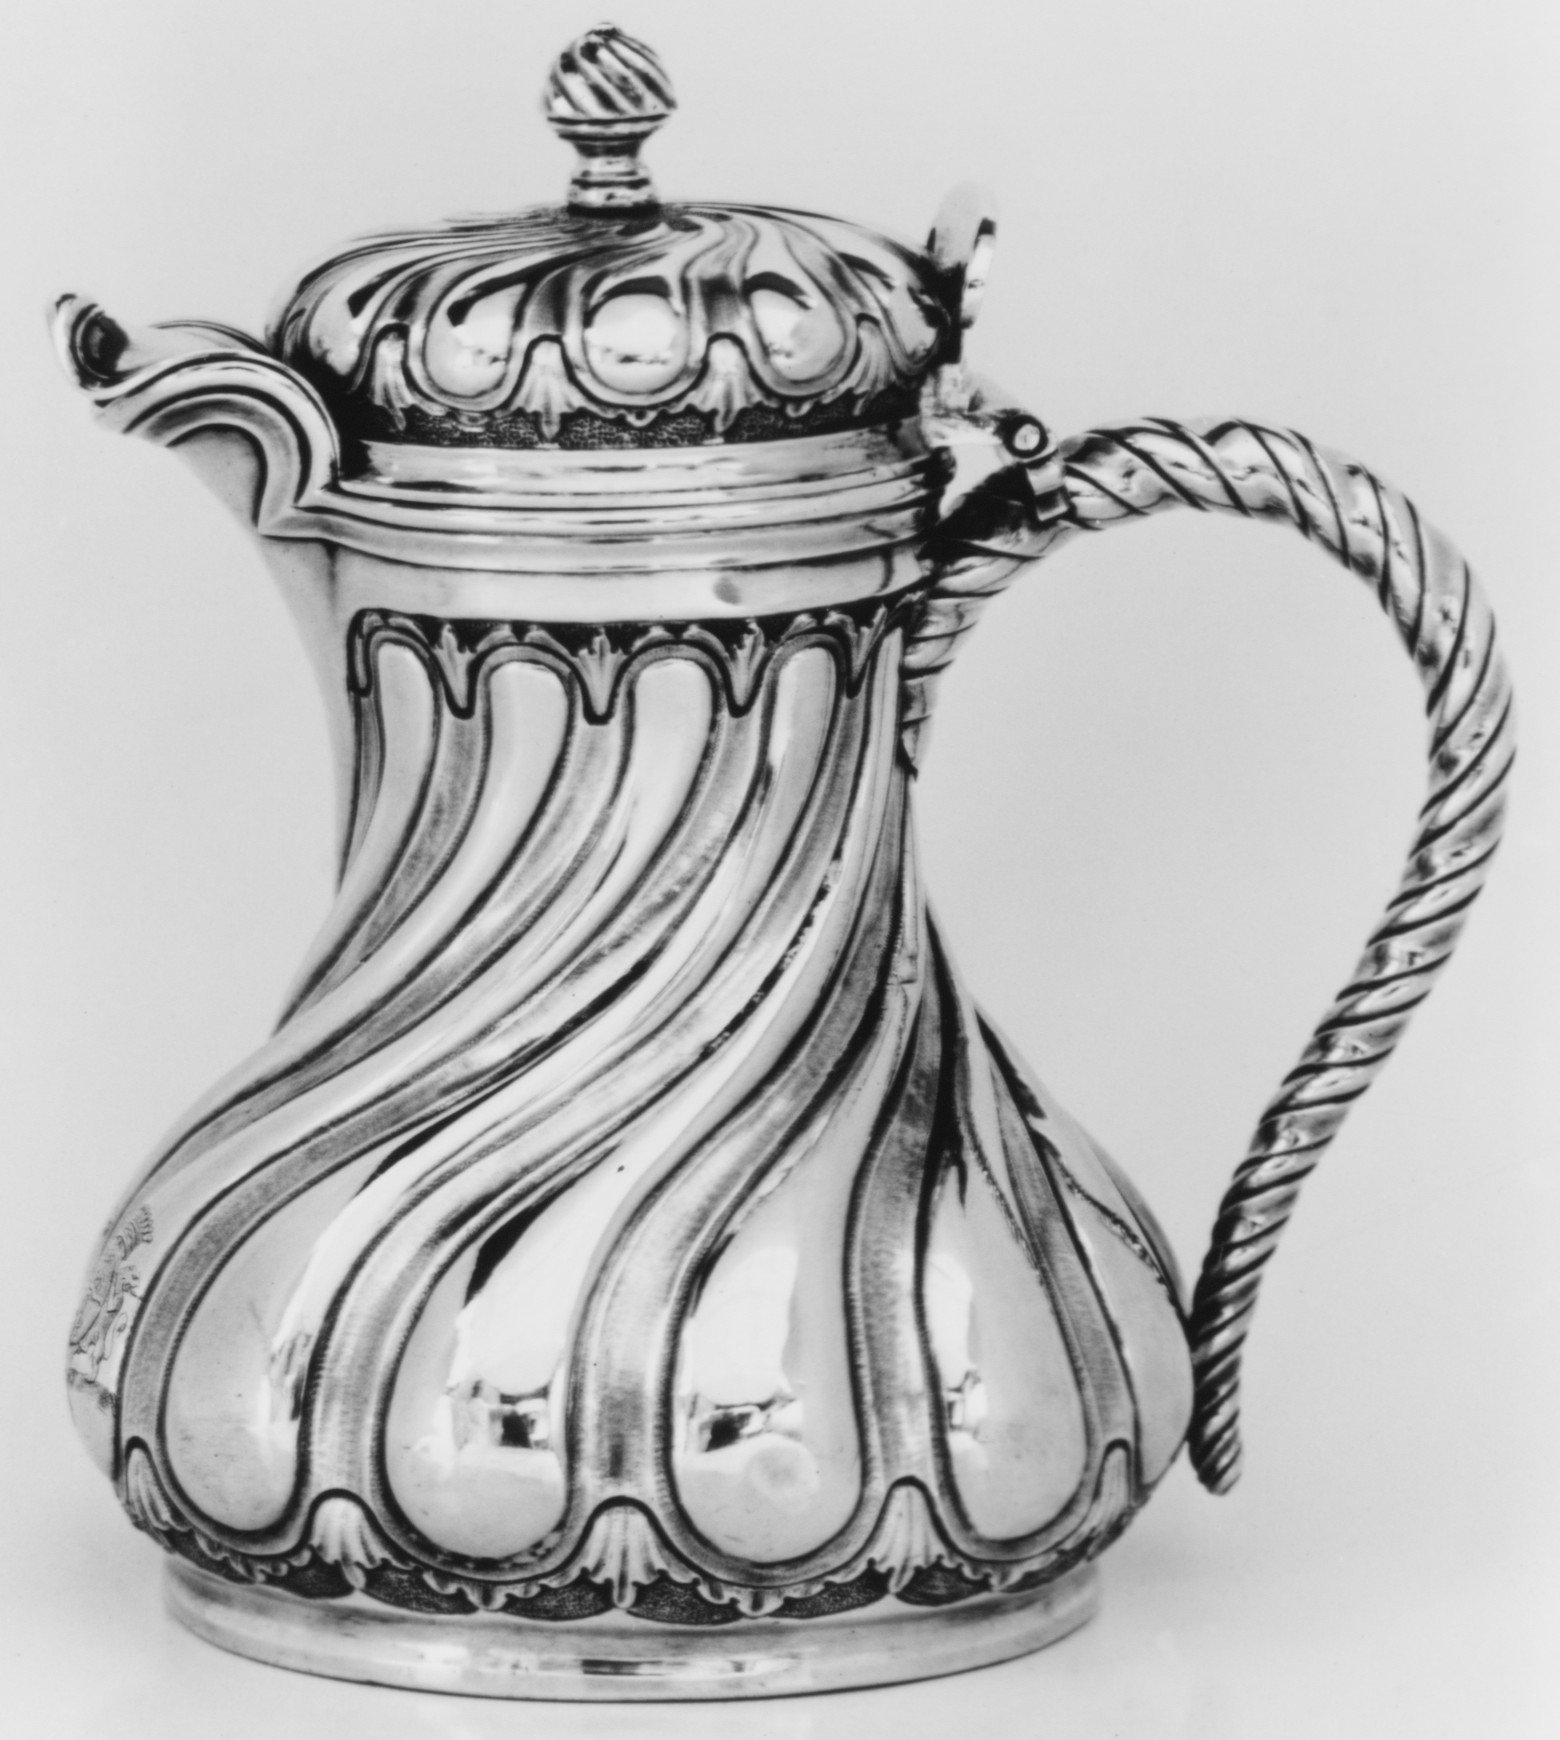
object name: coffeepot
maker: jean-baptiste vallot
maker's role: maker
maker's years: 1712-1811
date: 1744-1745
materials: silver